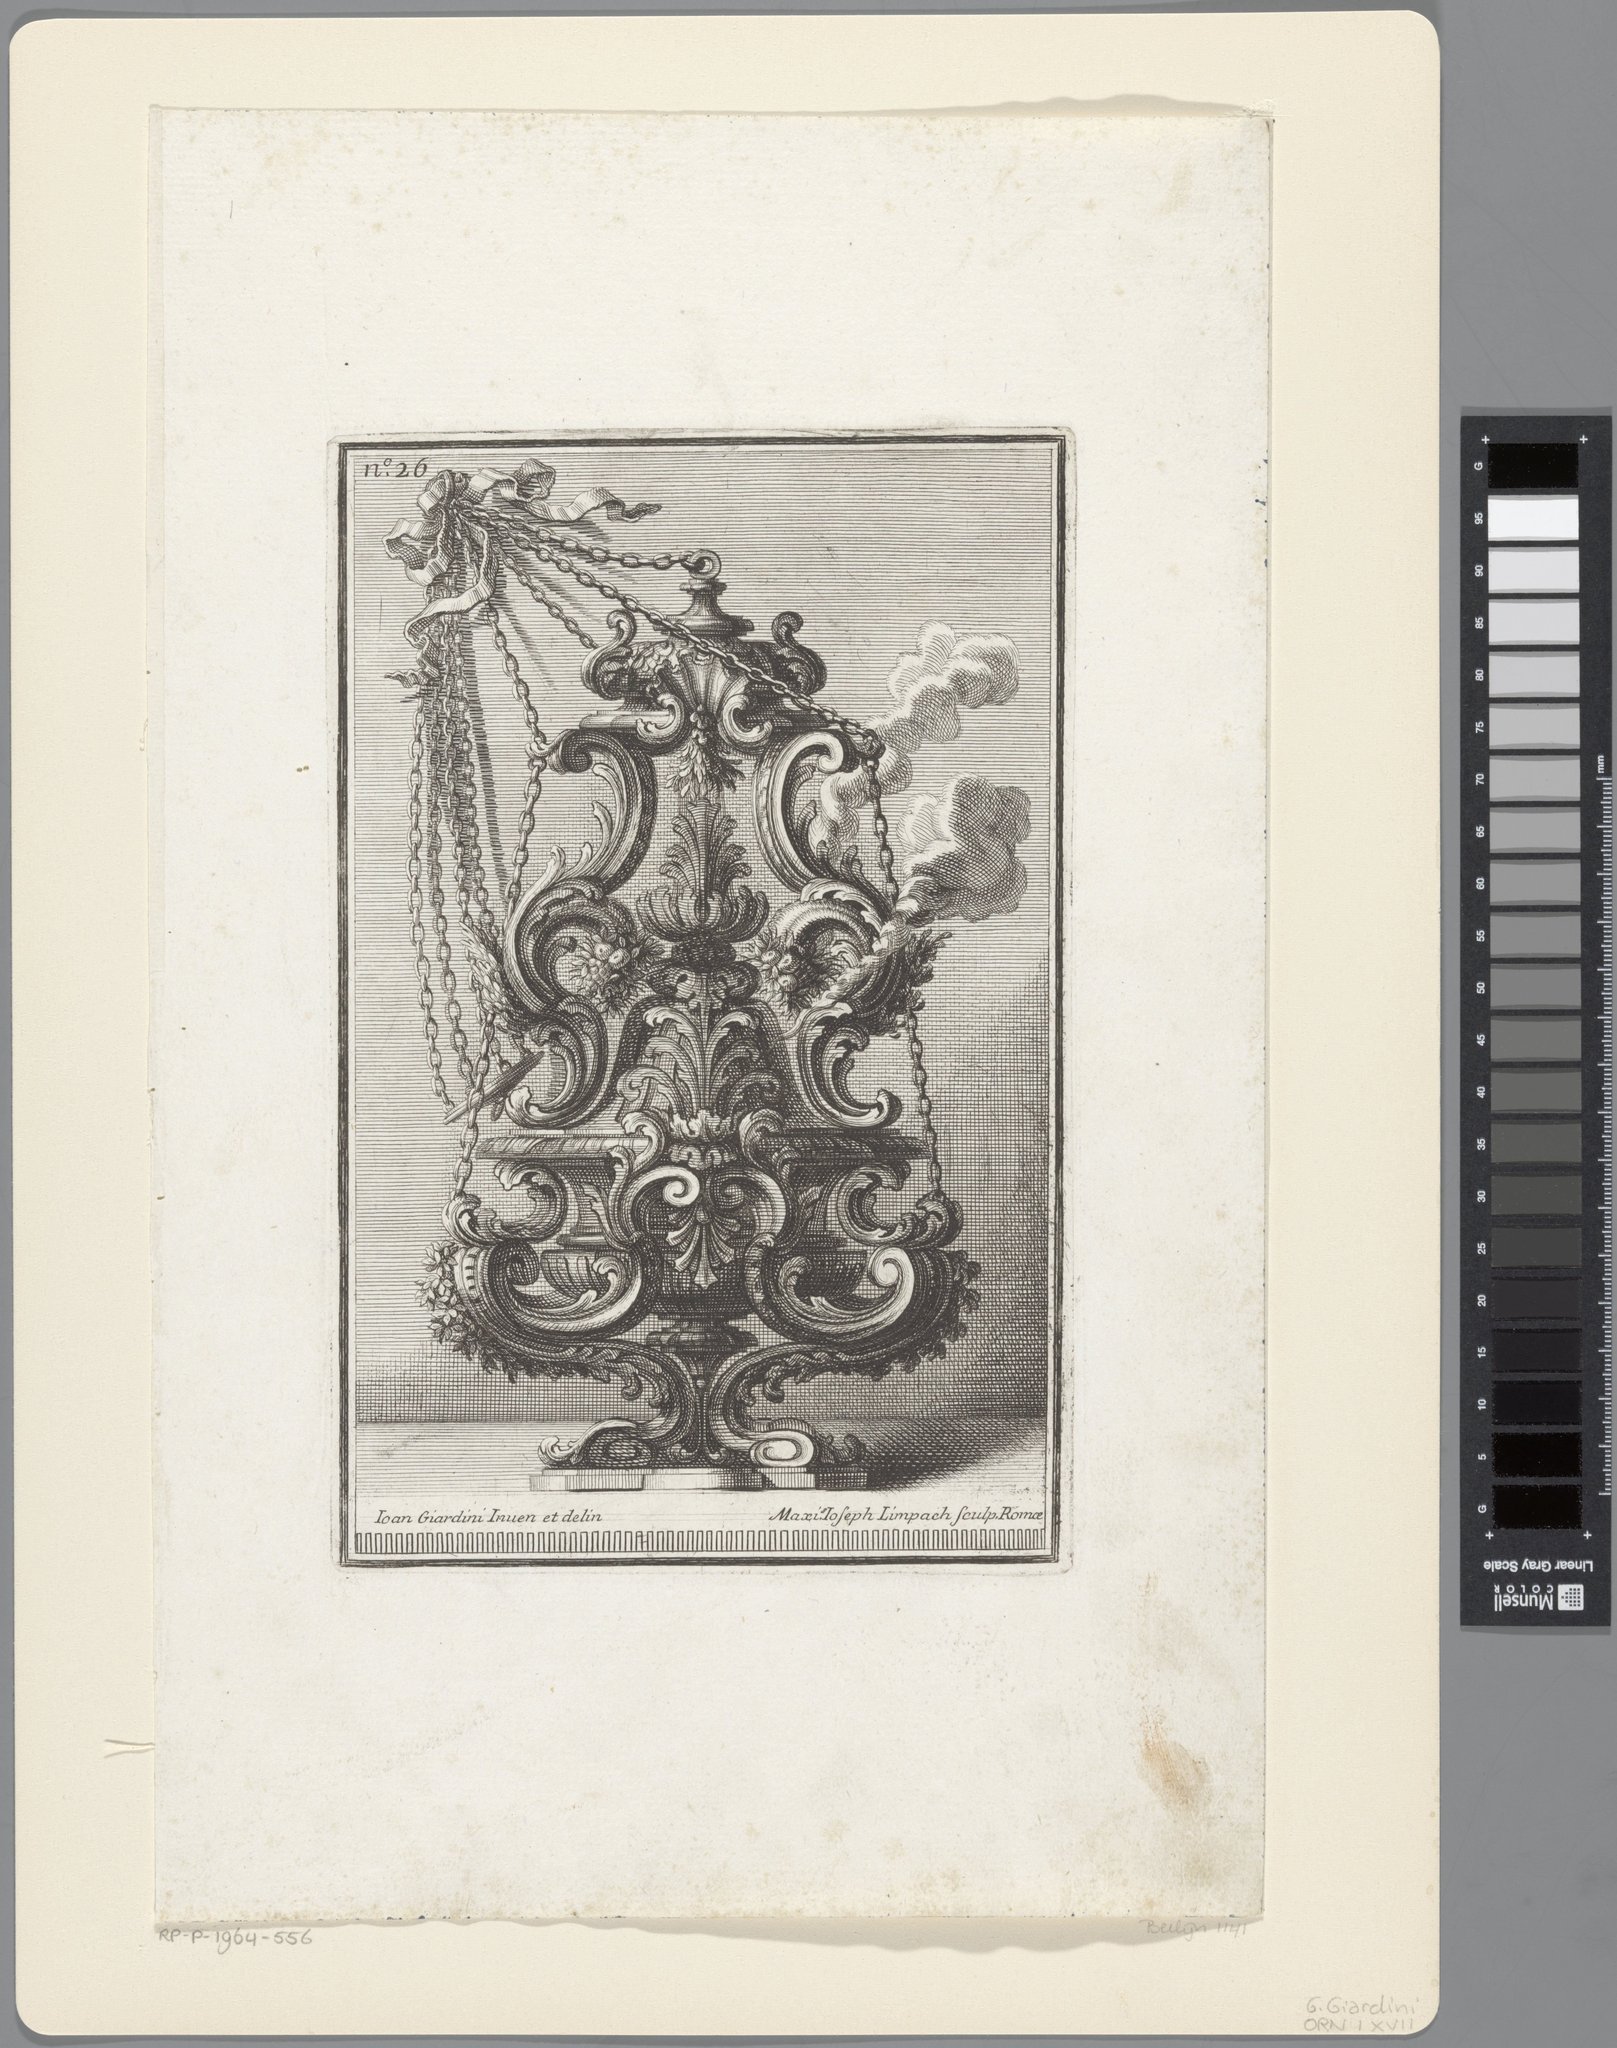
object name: ornament print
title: Diverse kerkelijke voorwerpen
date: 1714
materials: paper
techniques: etching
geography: italy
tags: censer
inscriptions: collector's mark: Lugt 2228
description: Prent maakt deel uit van een reeks van 100 ornamentprenten naar ontwerp van Giovanni Giardini.